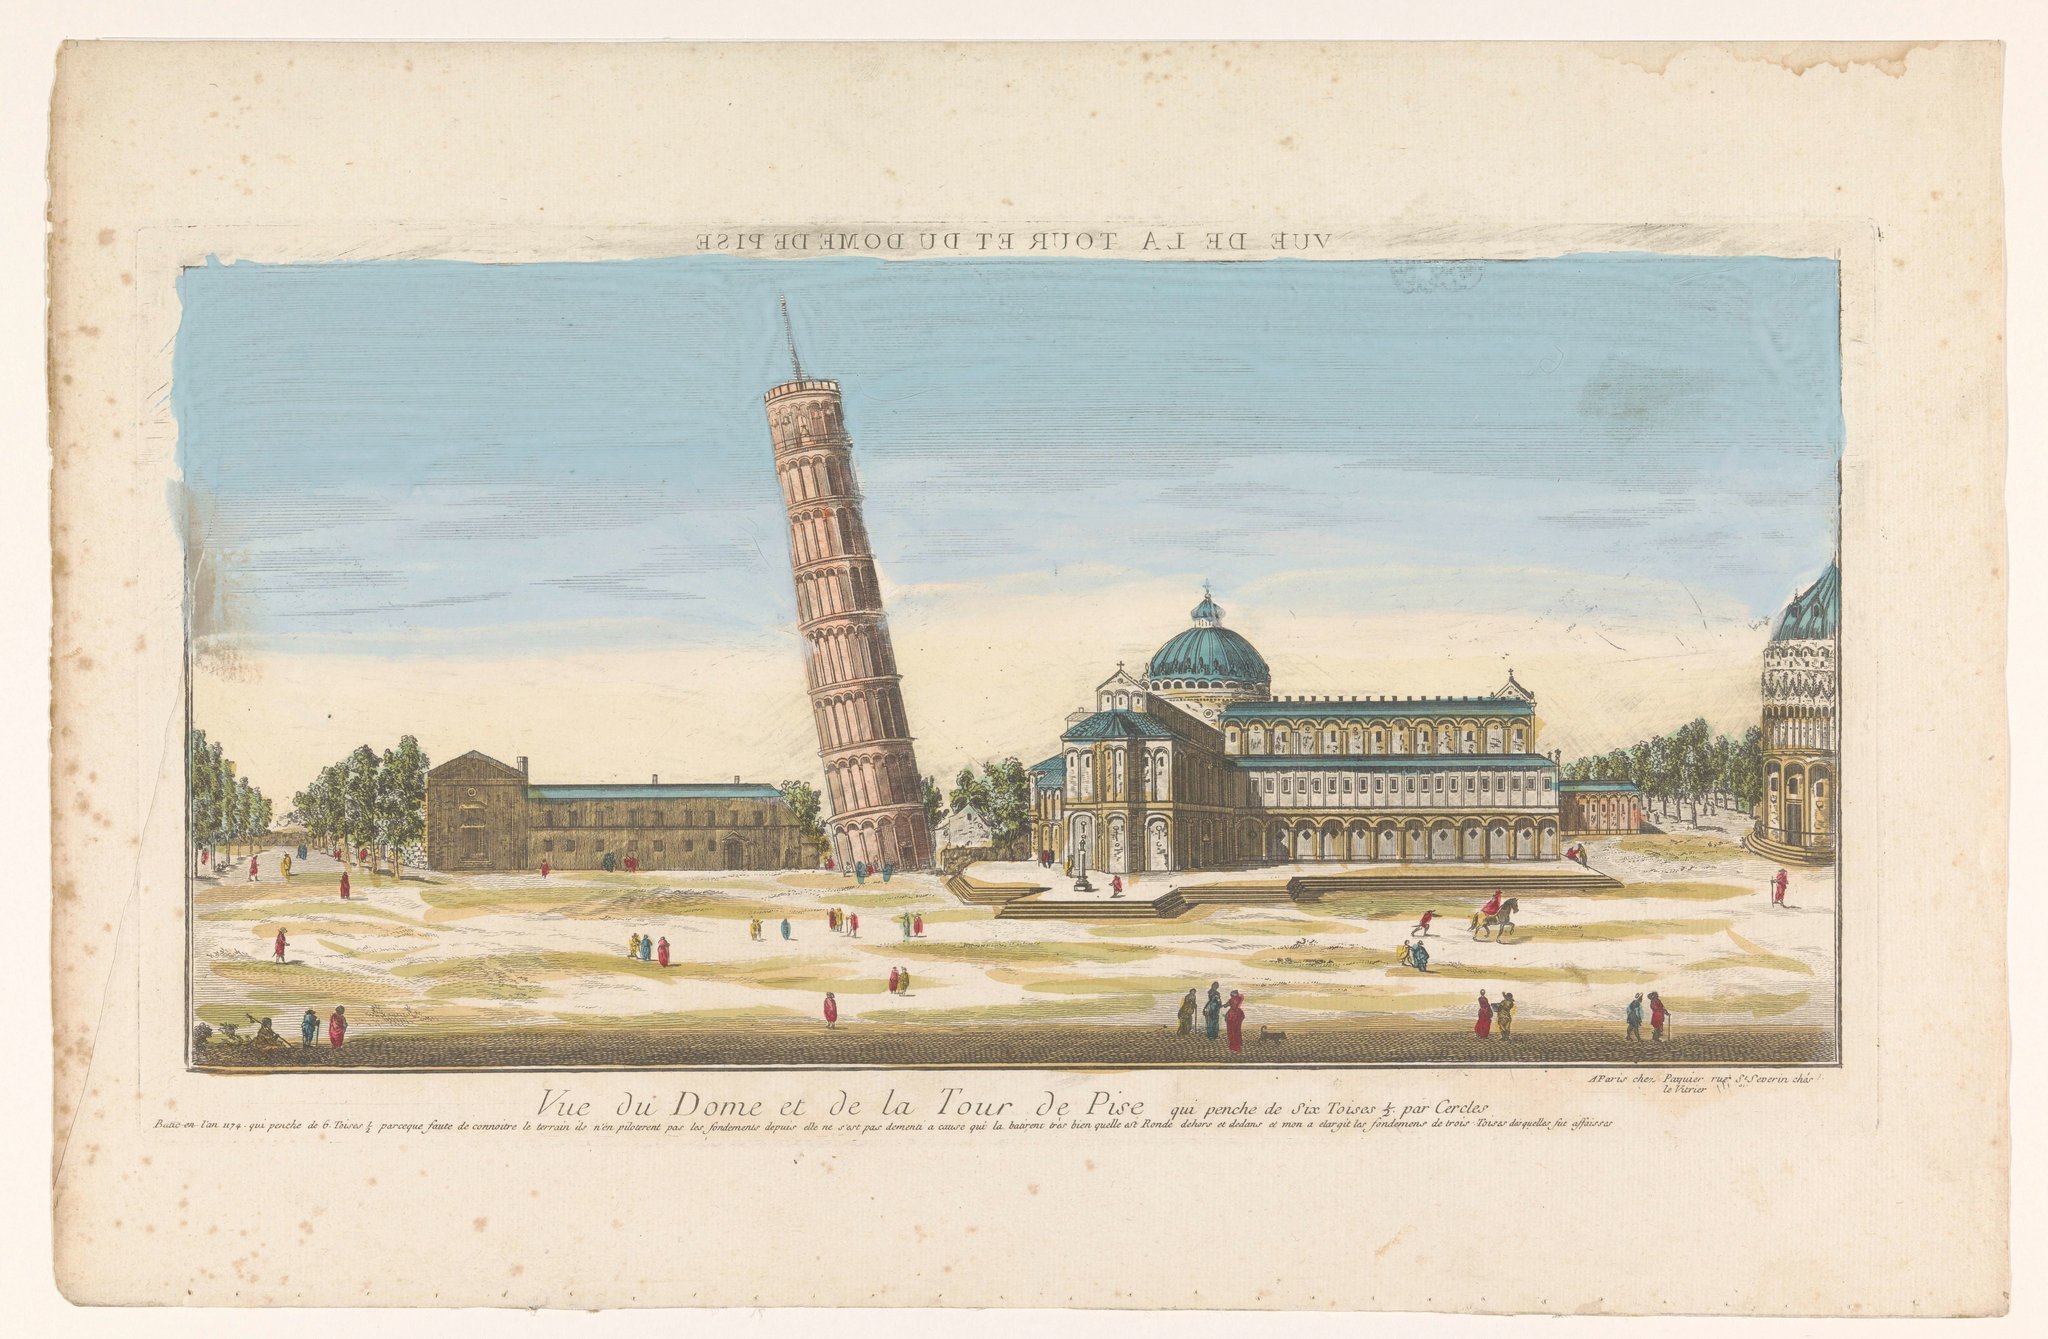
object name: print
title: Vue de la Tour et du Dome de Pise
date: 1700-1799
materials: paper, watercolor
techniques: brush, etching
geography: paris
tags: tower, clock tower ~ monumental adornment, church (exterior)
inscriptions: watermark, collector's mark: Lugt 2166